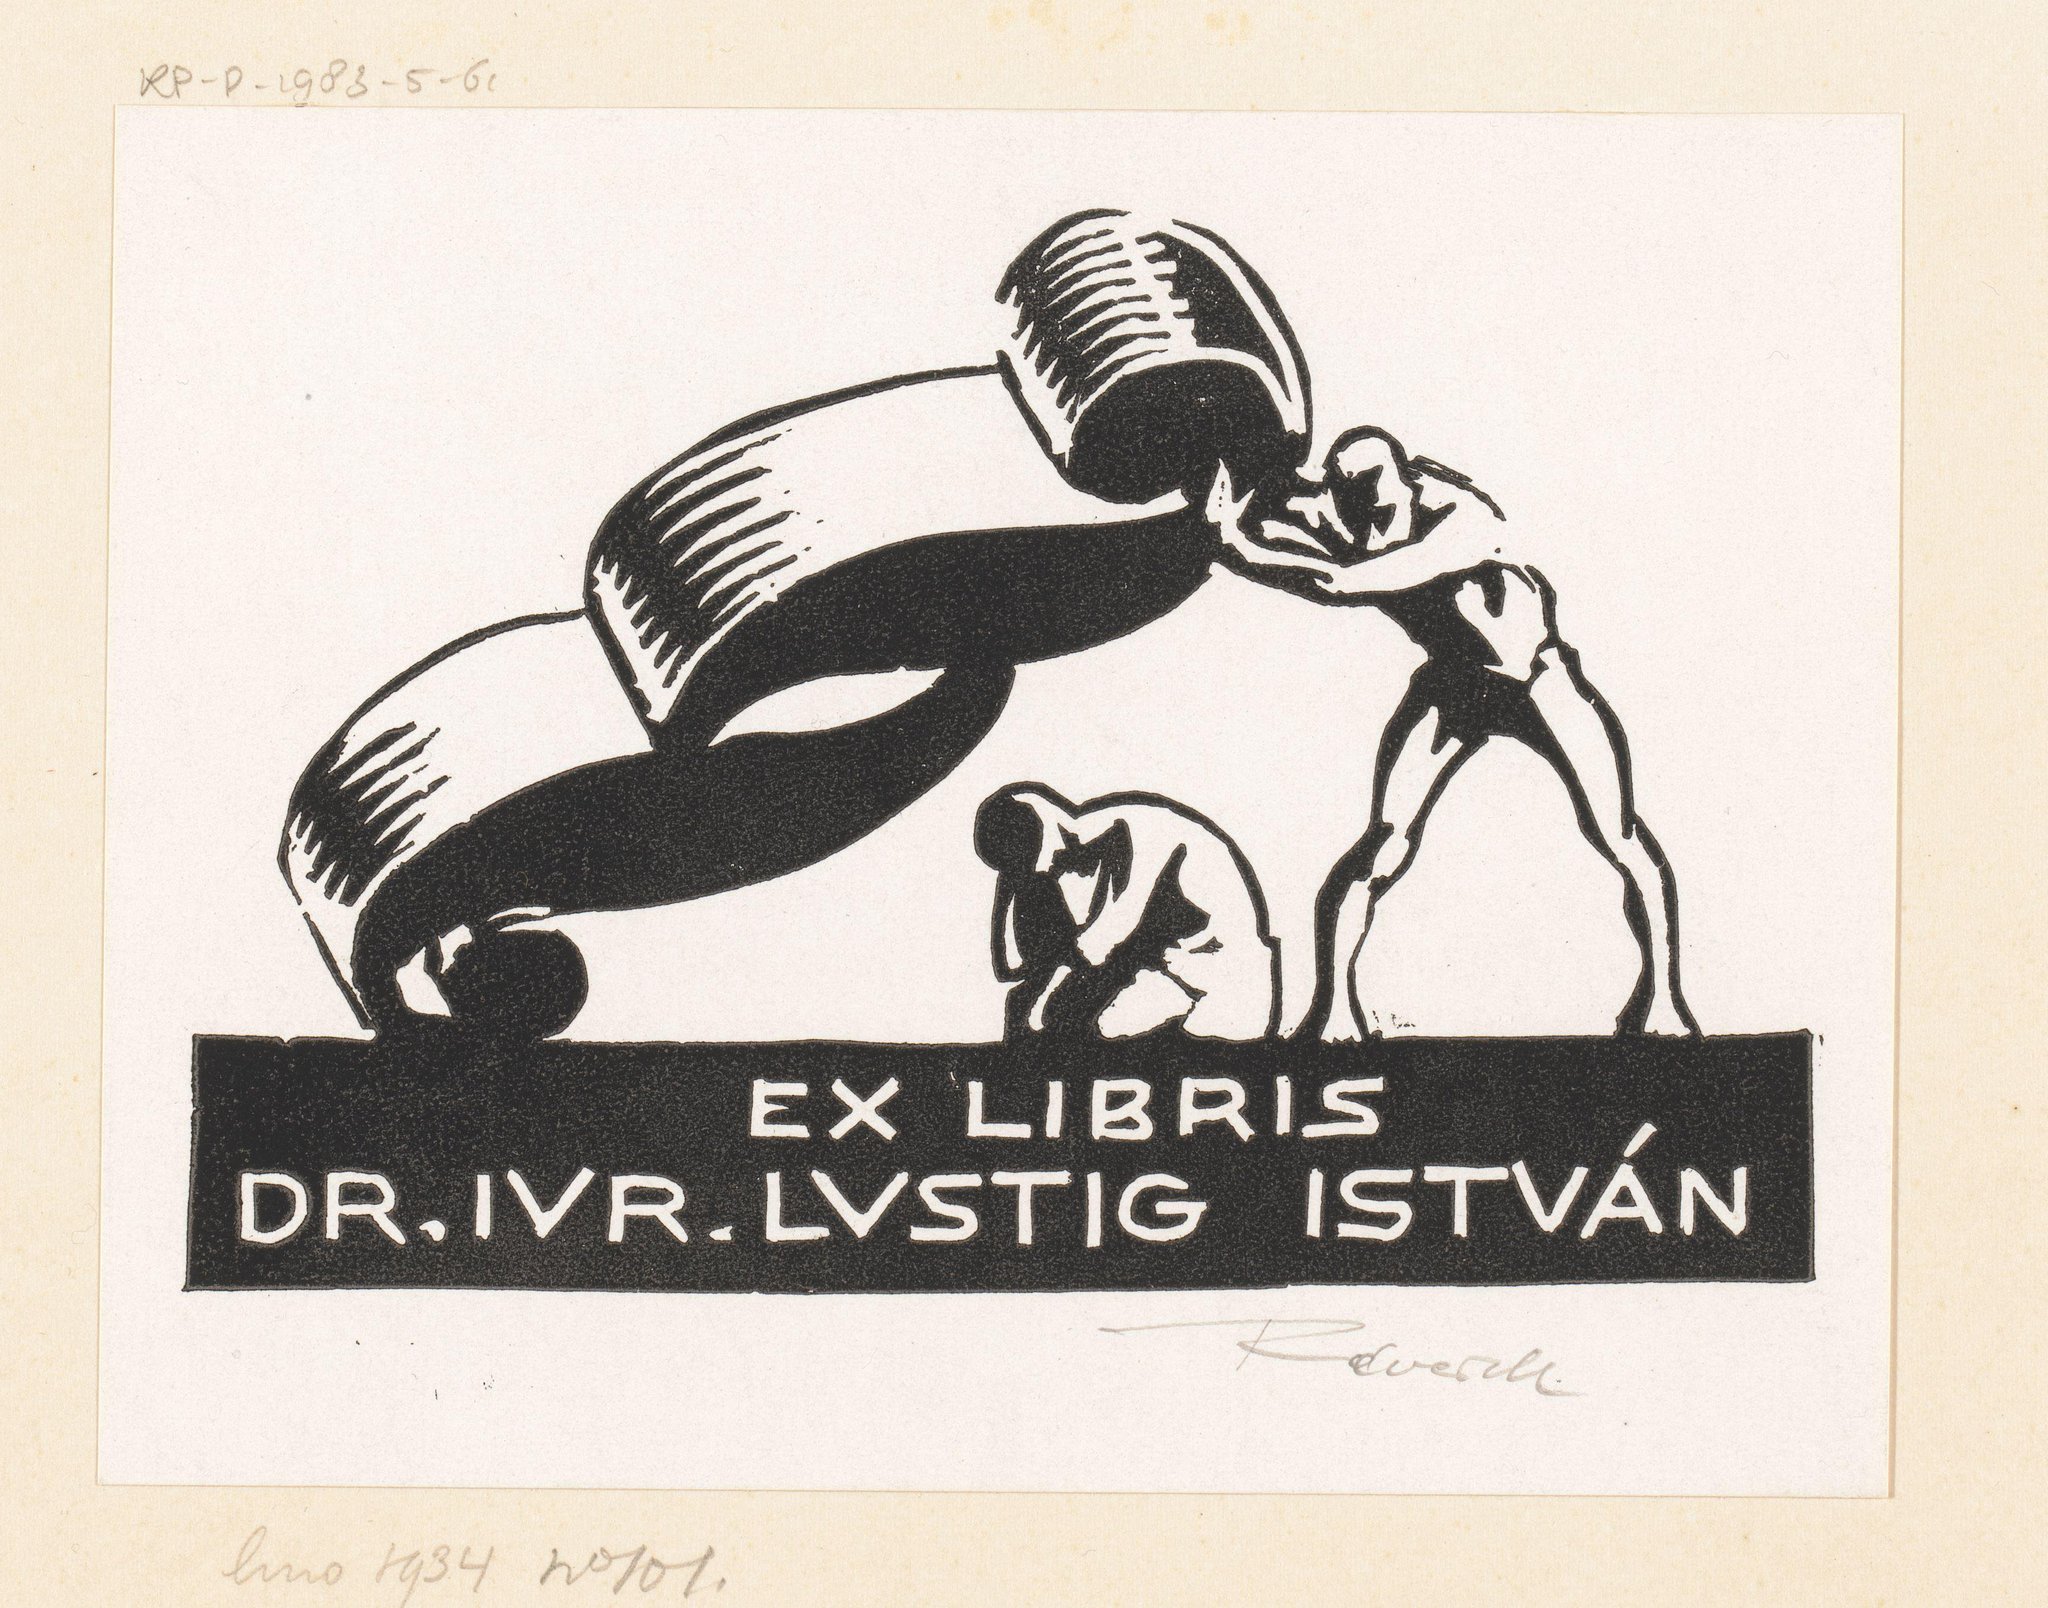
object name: bookplate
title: Ex libris dr. ivr. Lustig István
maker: kornél révész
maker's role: print maker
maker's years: 1885-1944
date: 1934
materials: paper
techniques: linocut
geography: budapest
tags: sitting figure, plants and herbs: clover, book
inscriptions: workshop stamp: ‘Fecit/ Révész Kornél/ Budapest’, signature: ‘Révész’, inscription: ‘lino 934’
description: Ex libris maakt deel uit van omslag met 64 ex libris op 34 losse opzetvellen, een catalogus en een tekstblad.